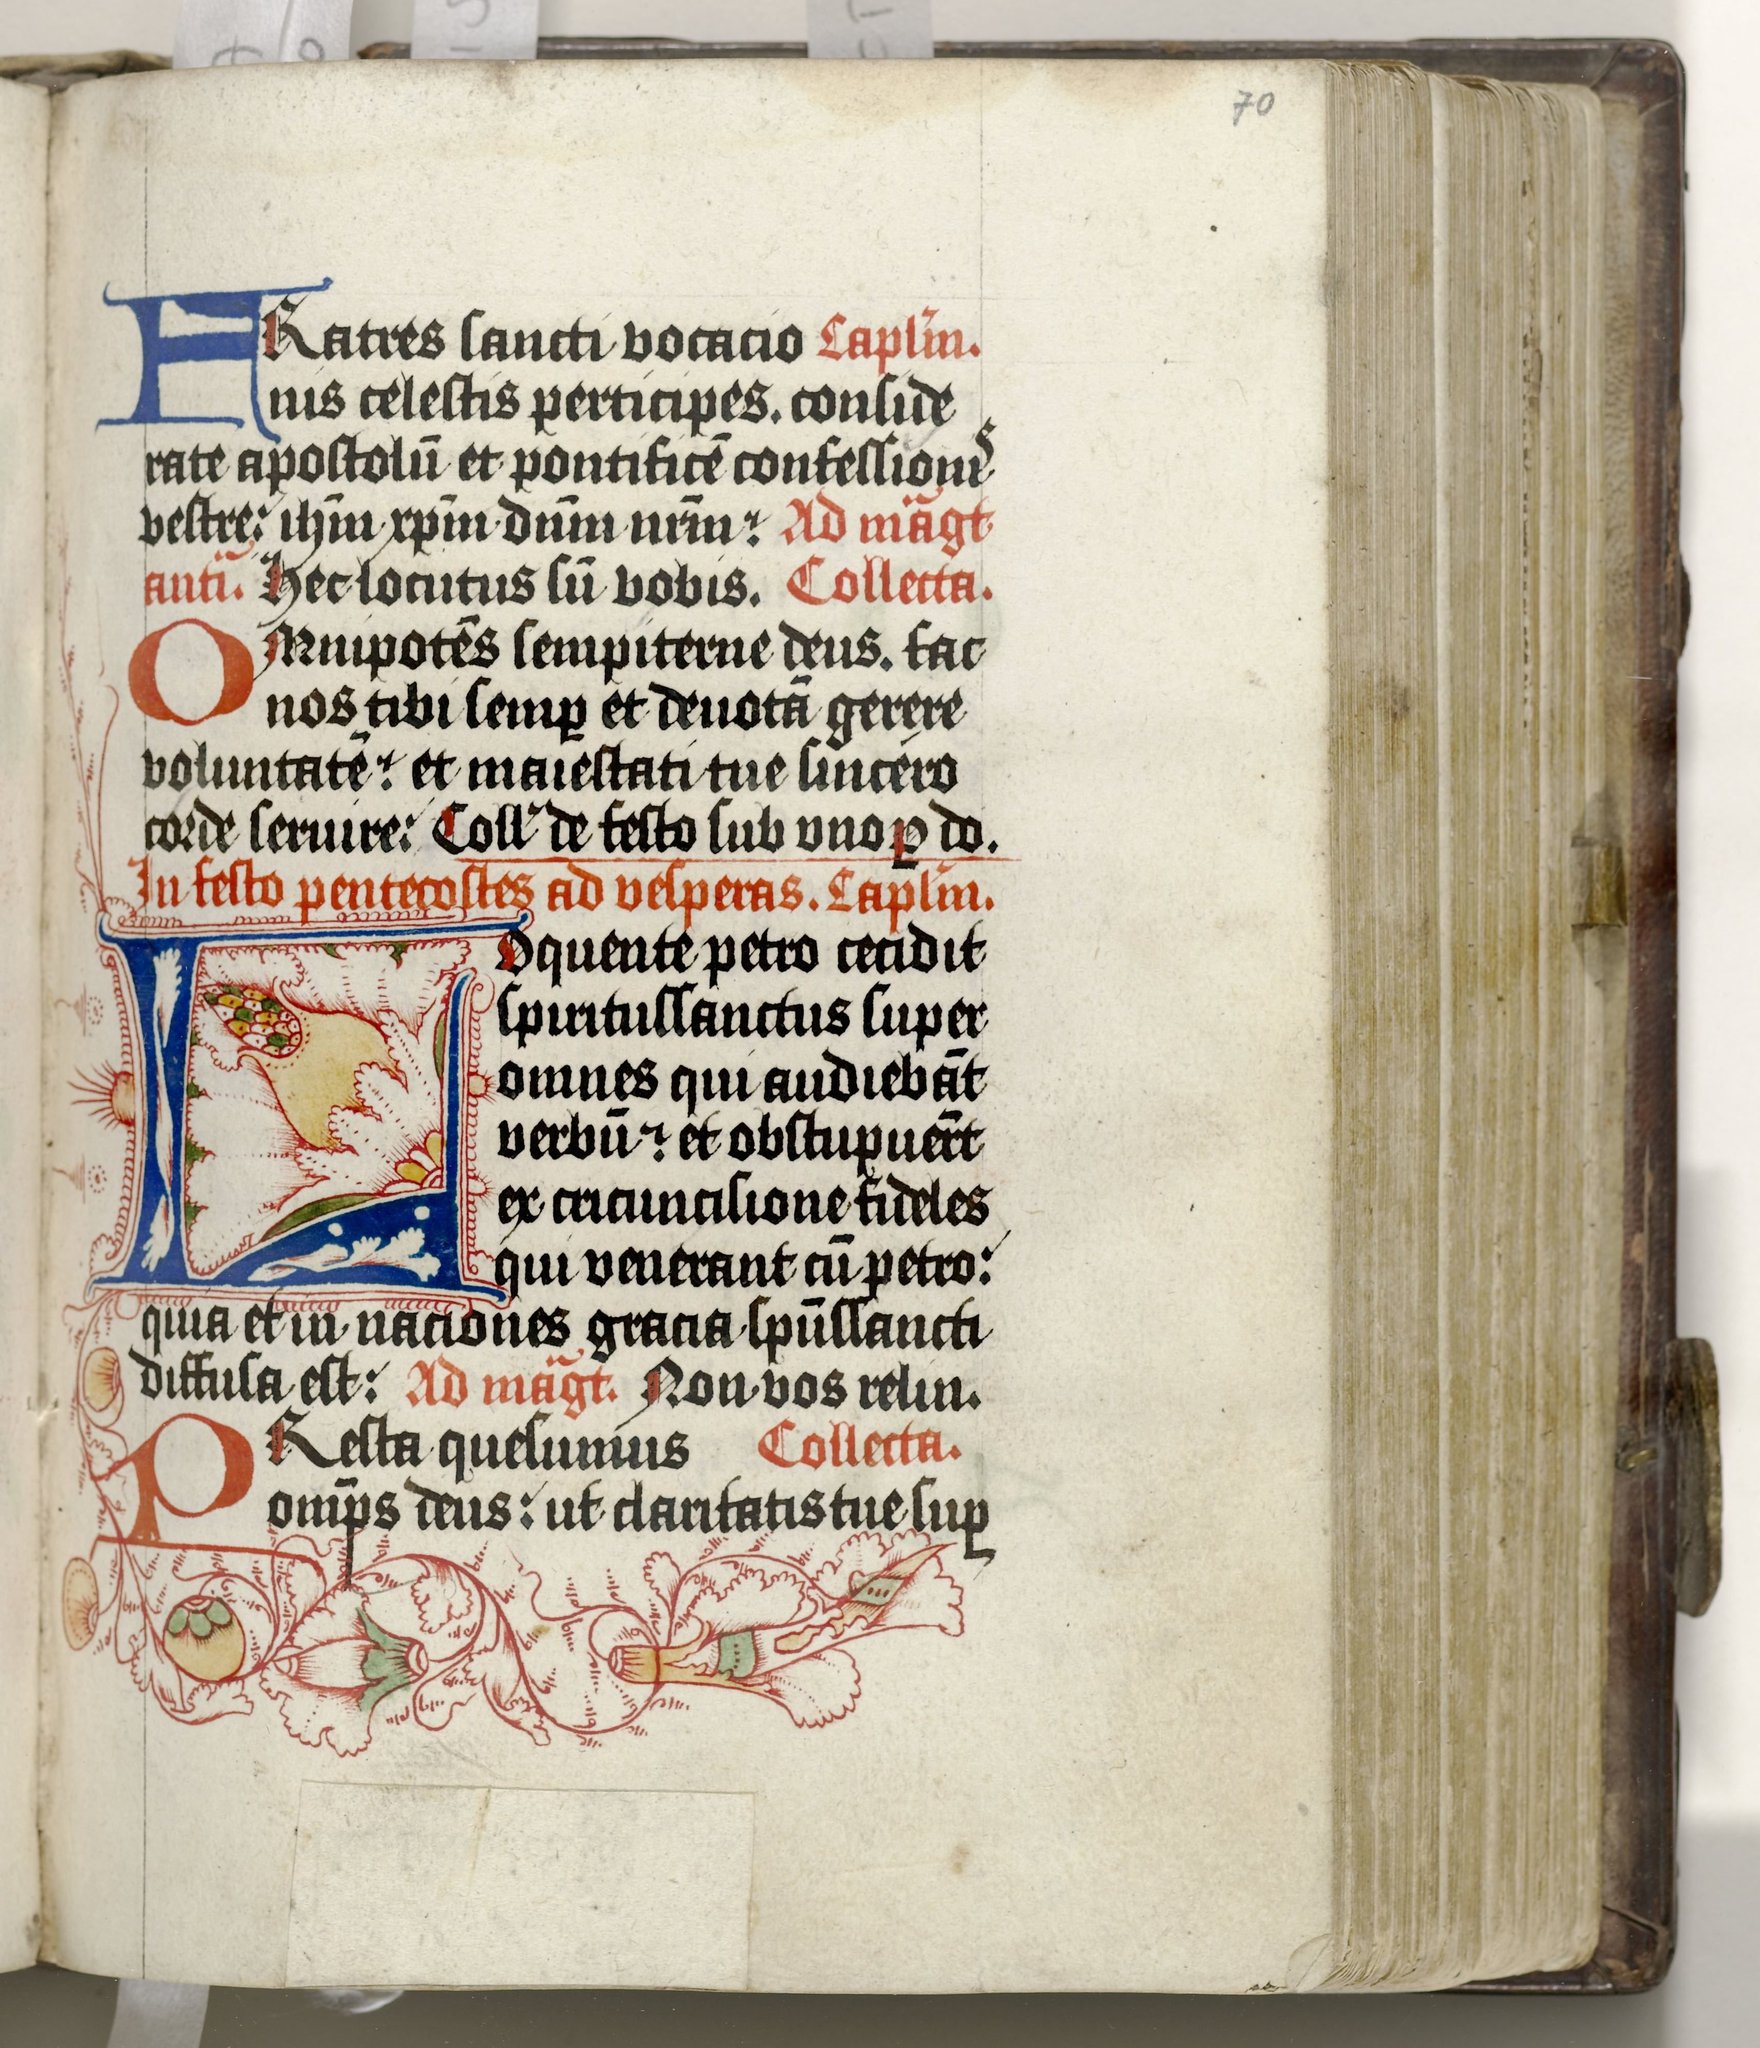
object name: book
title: Psalter en brevier (gedeeltes) in het Latijn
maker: Anonymous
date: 1500-1600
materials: paint, paper, parchment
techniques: pen in colors, brush in colors